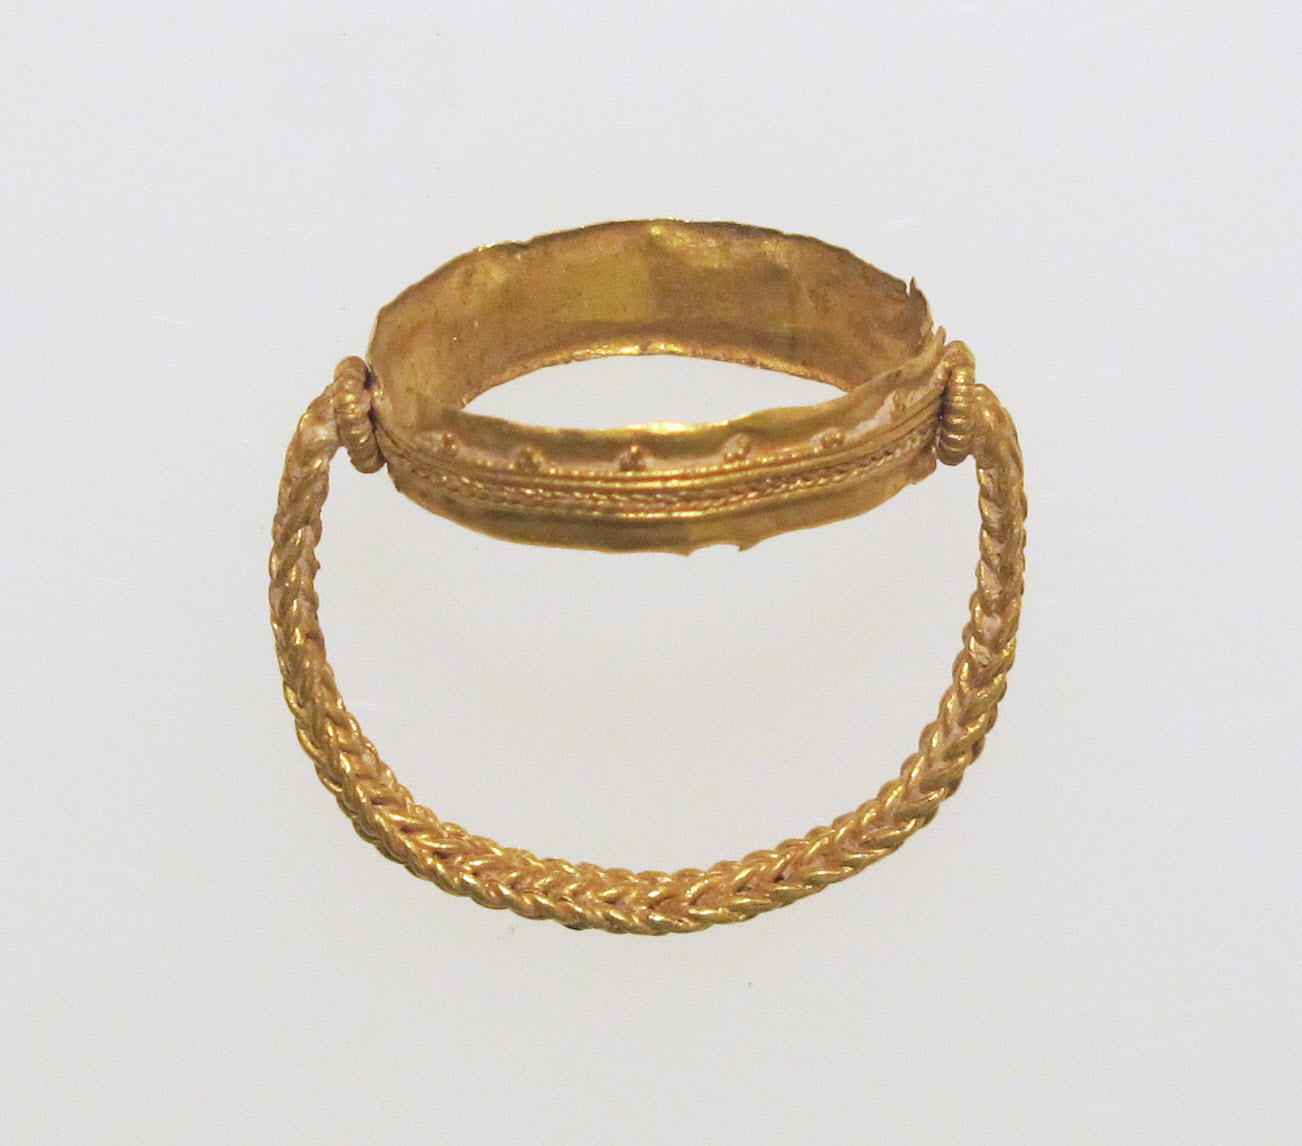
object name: ring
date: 7000 BCE-330 CE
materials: gold